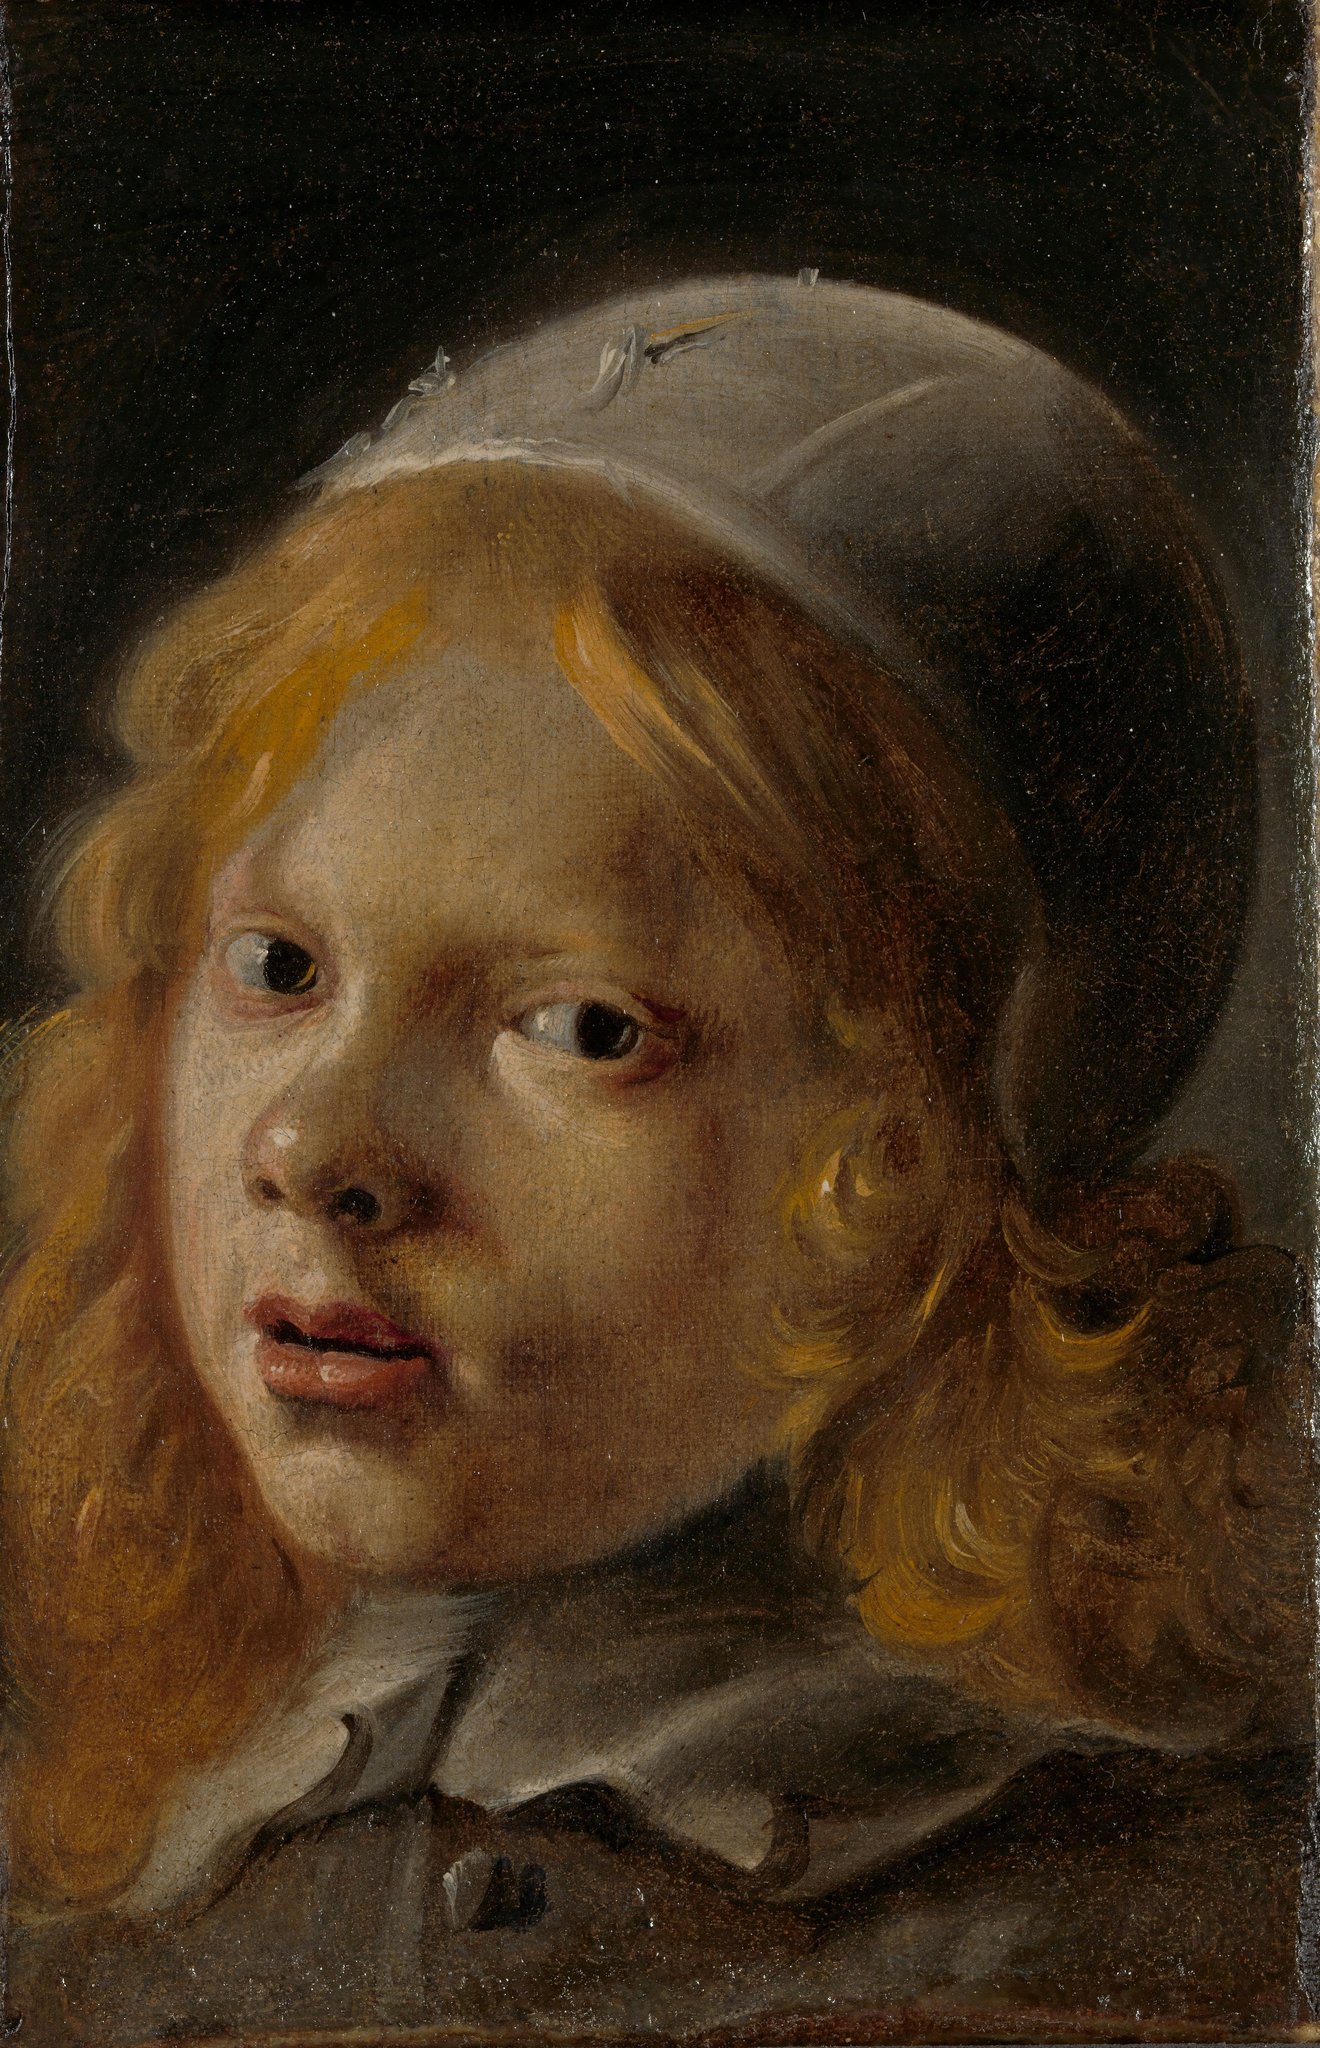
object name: painting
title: Self-portrait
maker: moses ter borch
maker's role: draughtsman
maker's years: 1645-1667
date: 1660-1661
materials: canvas, oil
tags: draughtsman, moses ter borch, portrait, self-portrait of painter, portrait, self-portrait of artist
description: Moses ter Borch must have been barely fifteen years old when he recorded his features on this small canvas with all the skill of an experienced master. He peers out at us with the same searching gaze with which he looked at himself in the mirror. A ray of light grazes his young adolescent face framed by golden locks of hair.